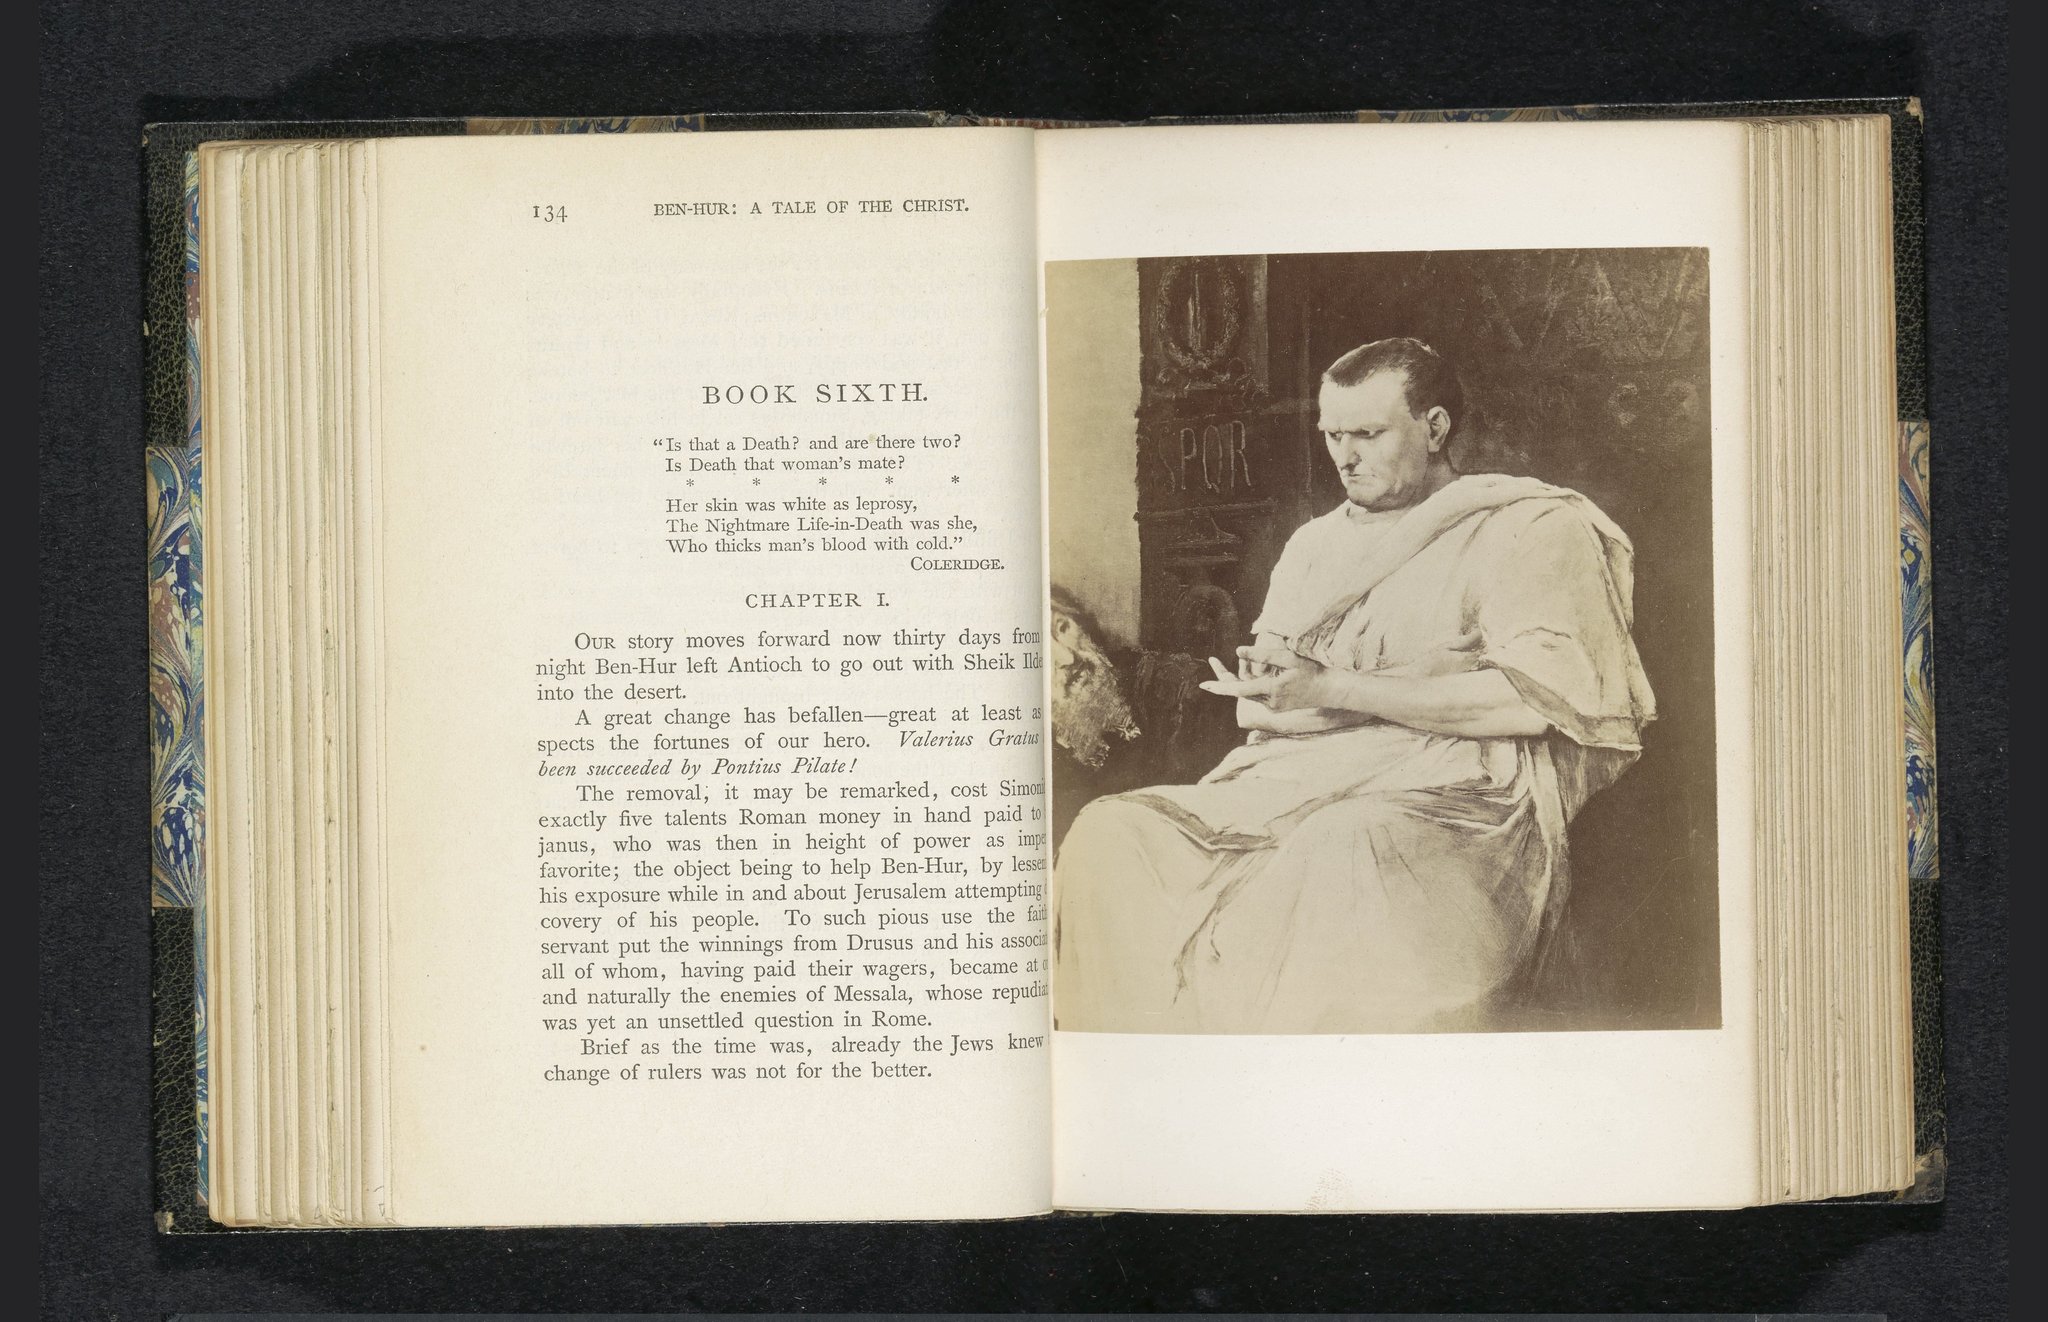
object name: page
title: Fotoreproductie van een schilderij, voorstellende een portret van Pontius Pilatus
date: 1883-1888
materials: photographic support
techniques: albumen print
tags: christ before pontius pilate (matthew 27:11-26; mark 15:2-15; luke 23:2-7, 23:13-25; john 18:28 - 19:16)